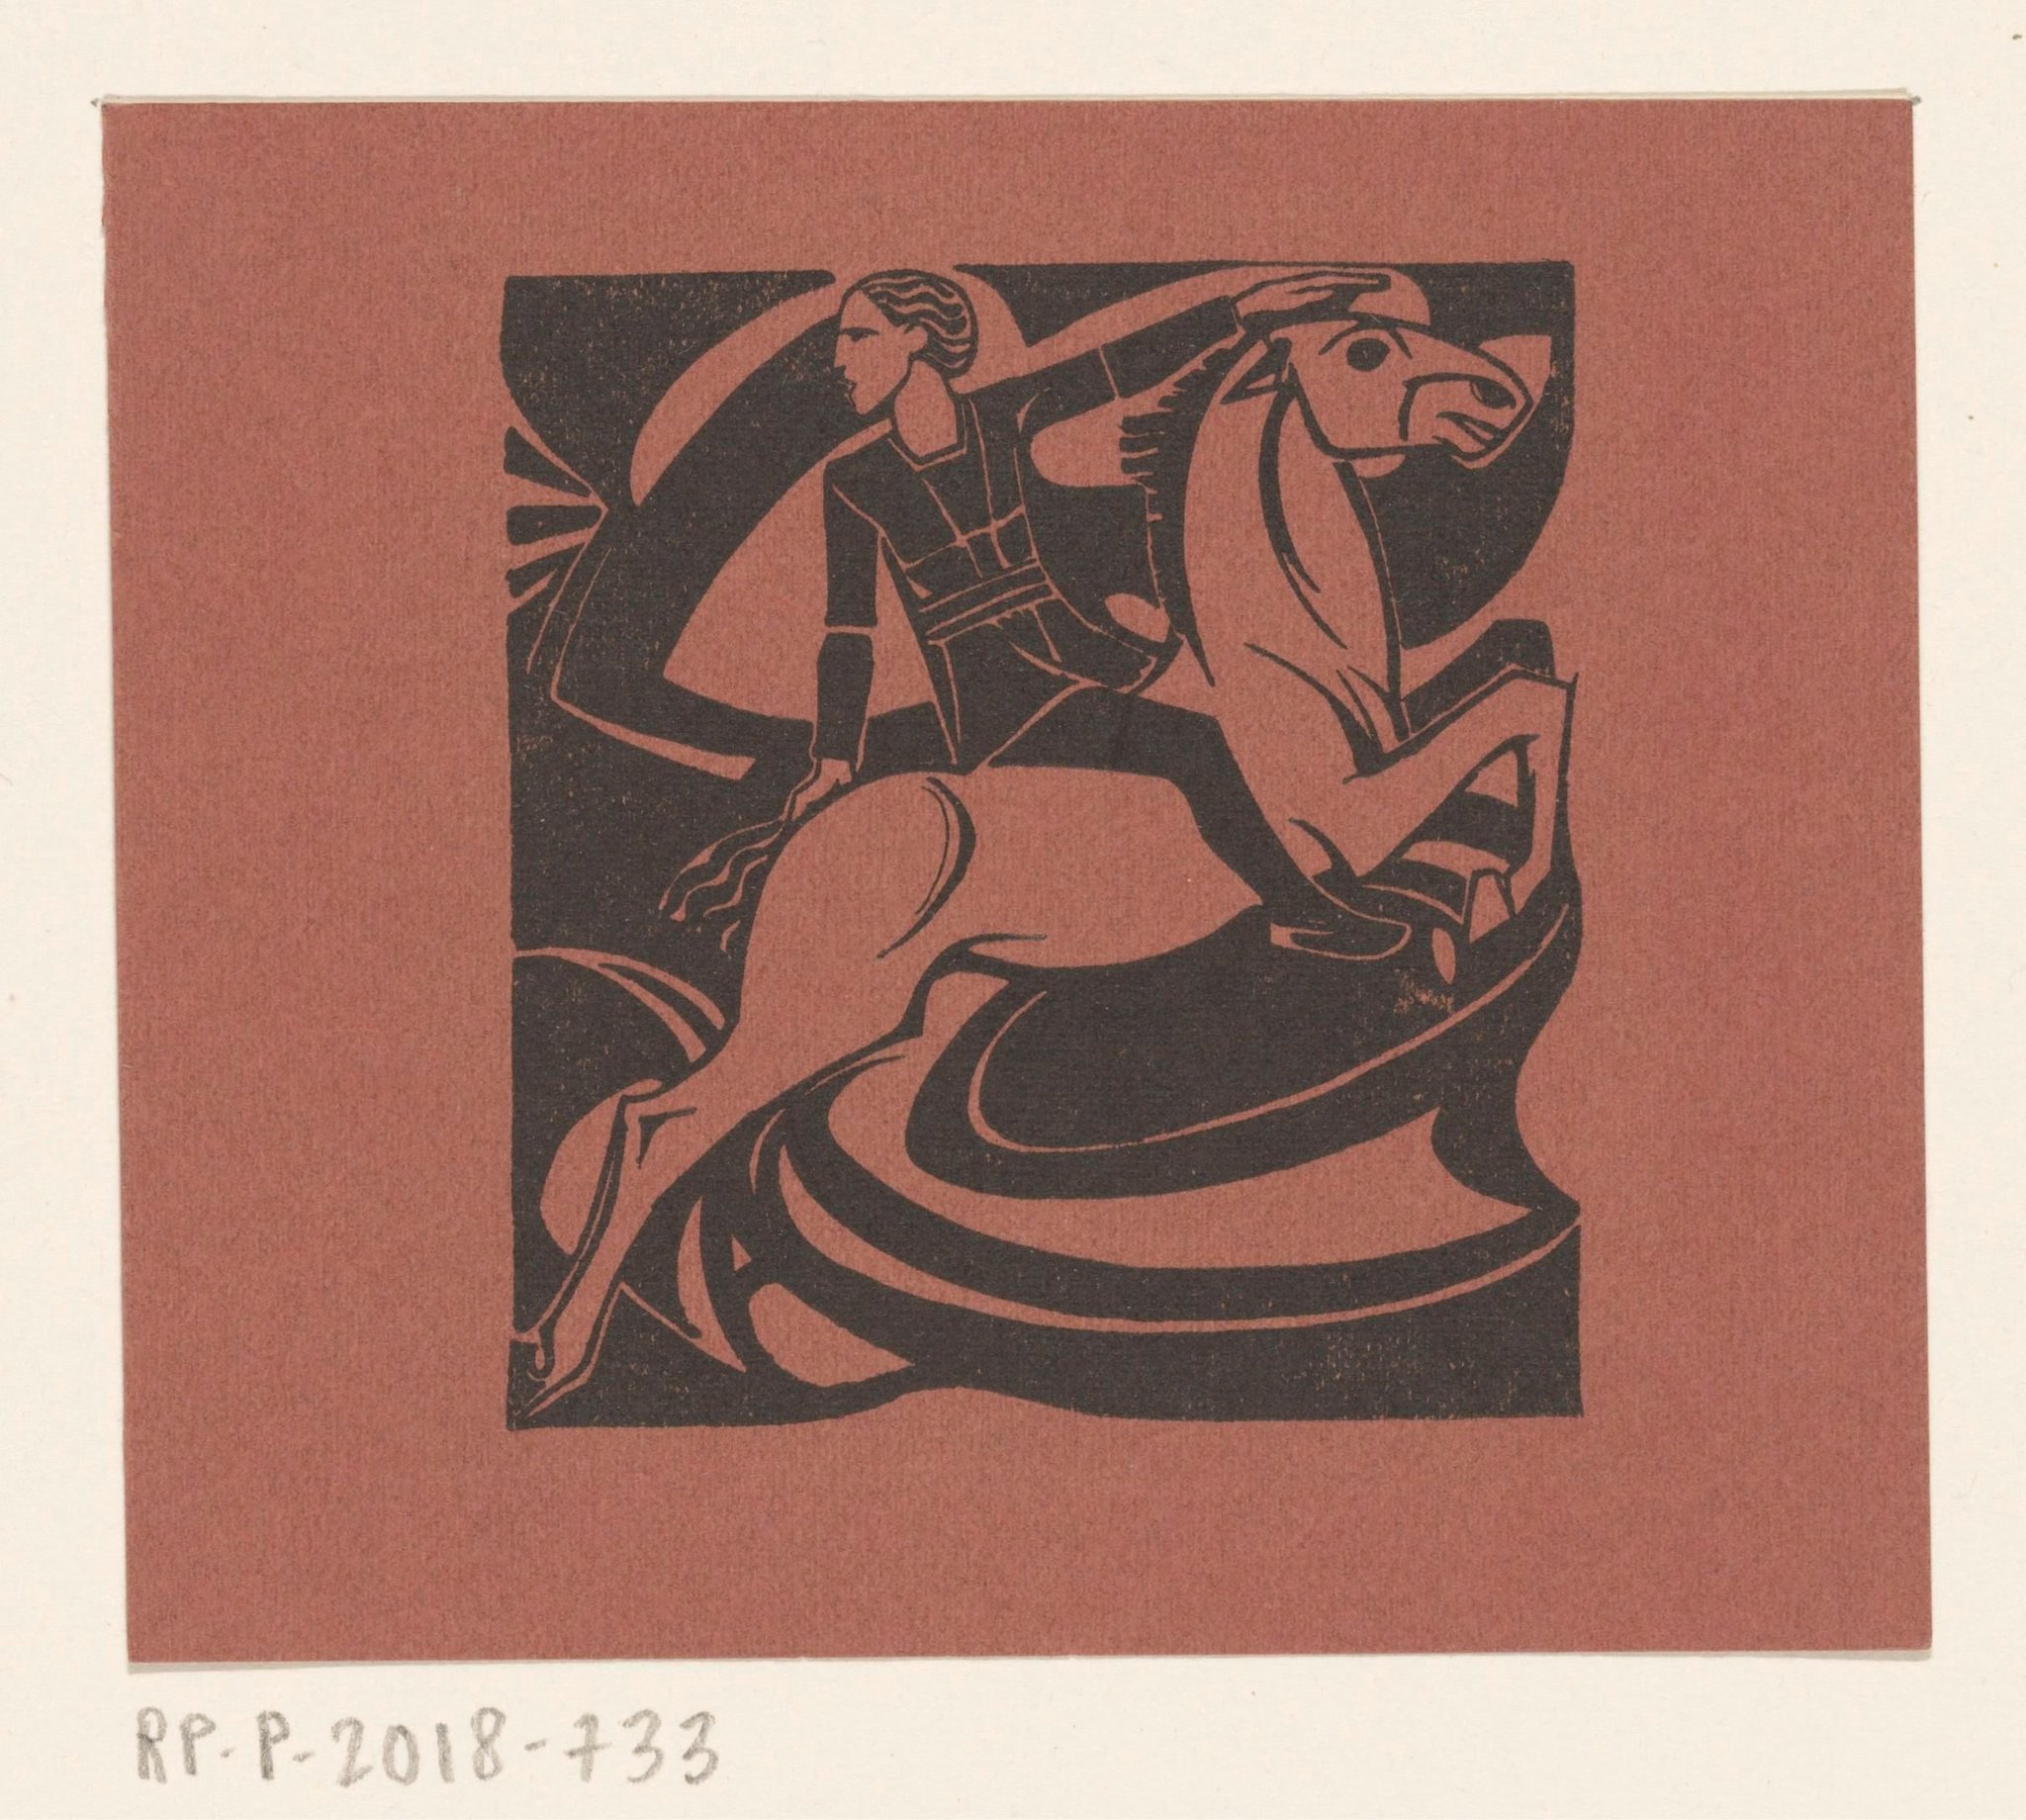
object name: print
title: Ruiter op een springend paard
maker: richard nicolaüs roland holst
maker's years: 1868-1938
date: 1878-1938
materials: paper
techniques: woodcut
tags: riding a horse, ass, or mule; rider, horseman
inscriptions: number: ‘33’